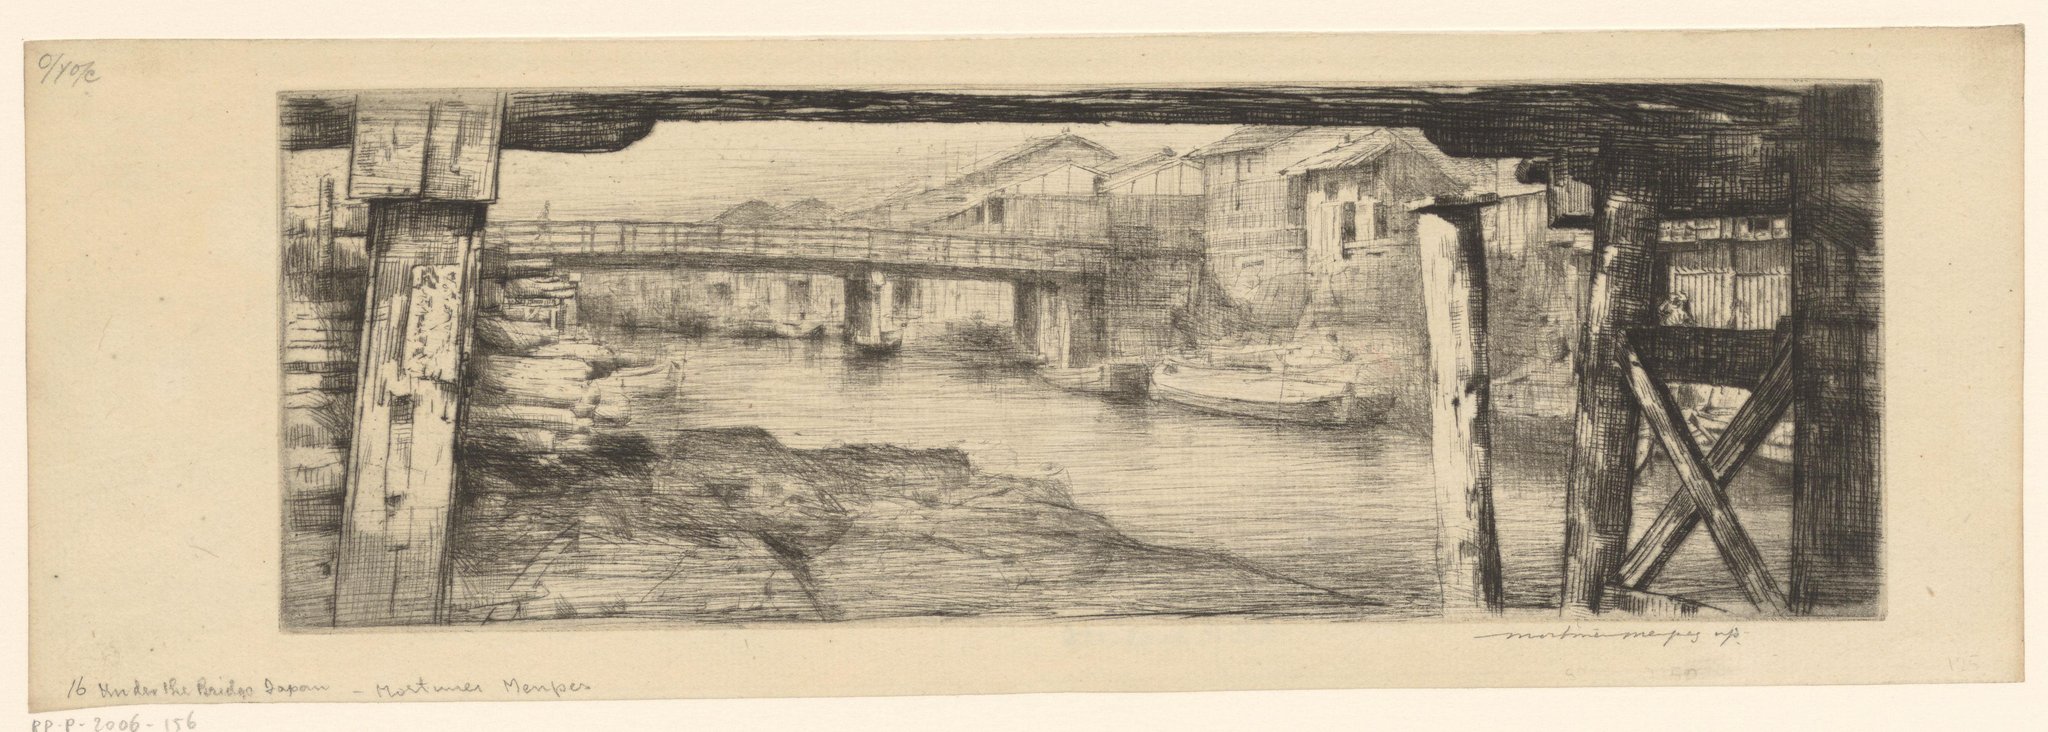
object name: print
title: Gezicht op huizen aan een rivier vanonder een brug in Japan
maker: mortimer l. menpes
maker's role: print maker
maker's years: 1855-1938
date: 1914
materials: paper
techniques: drypoint, intaglio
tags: bridge in city across river, canal, etc., japan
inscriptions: signature: ‘Mortimer Menpes’, collector's mark: Lugt 2760, collector's mark: Lugt 2228, title: ‘Under the bridge, Japan’